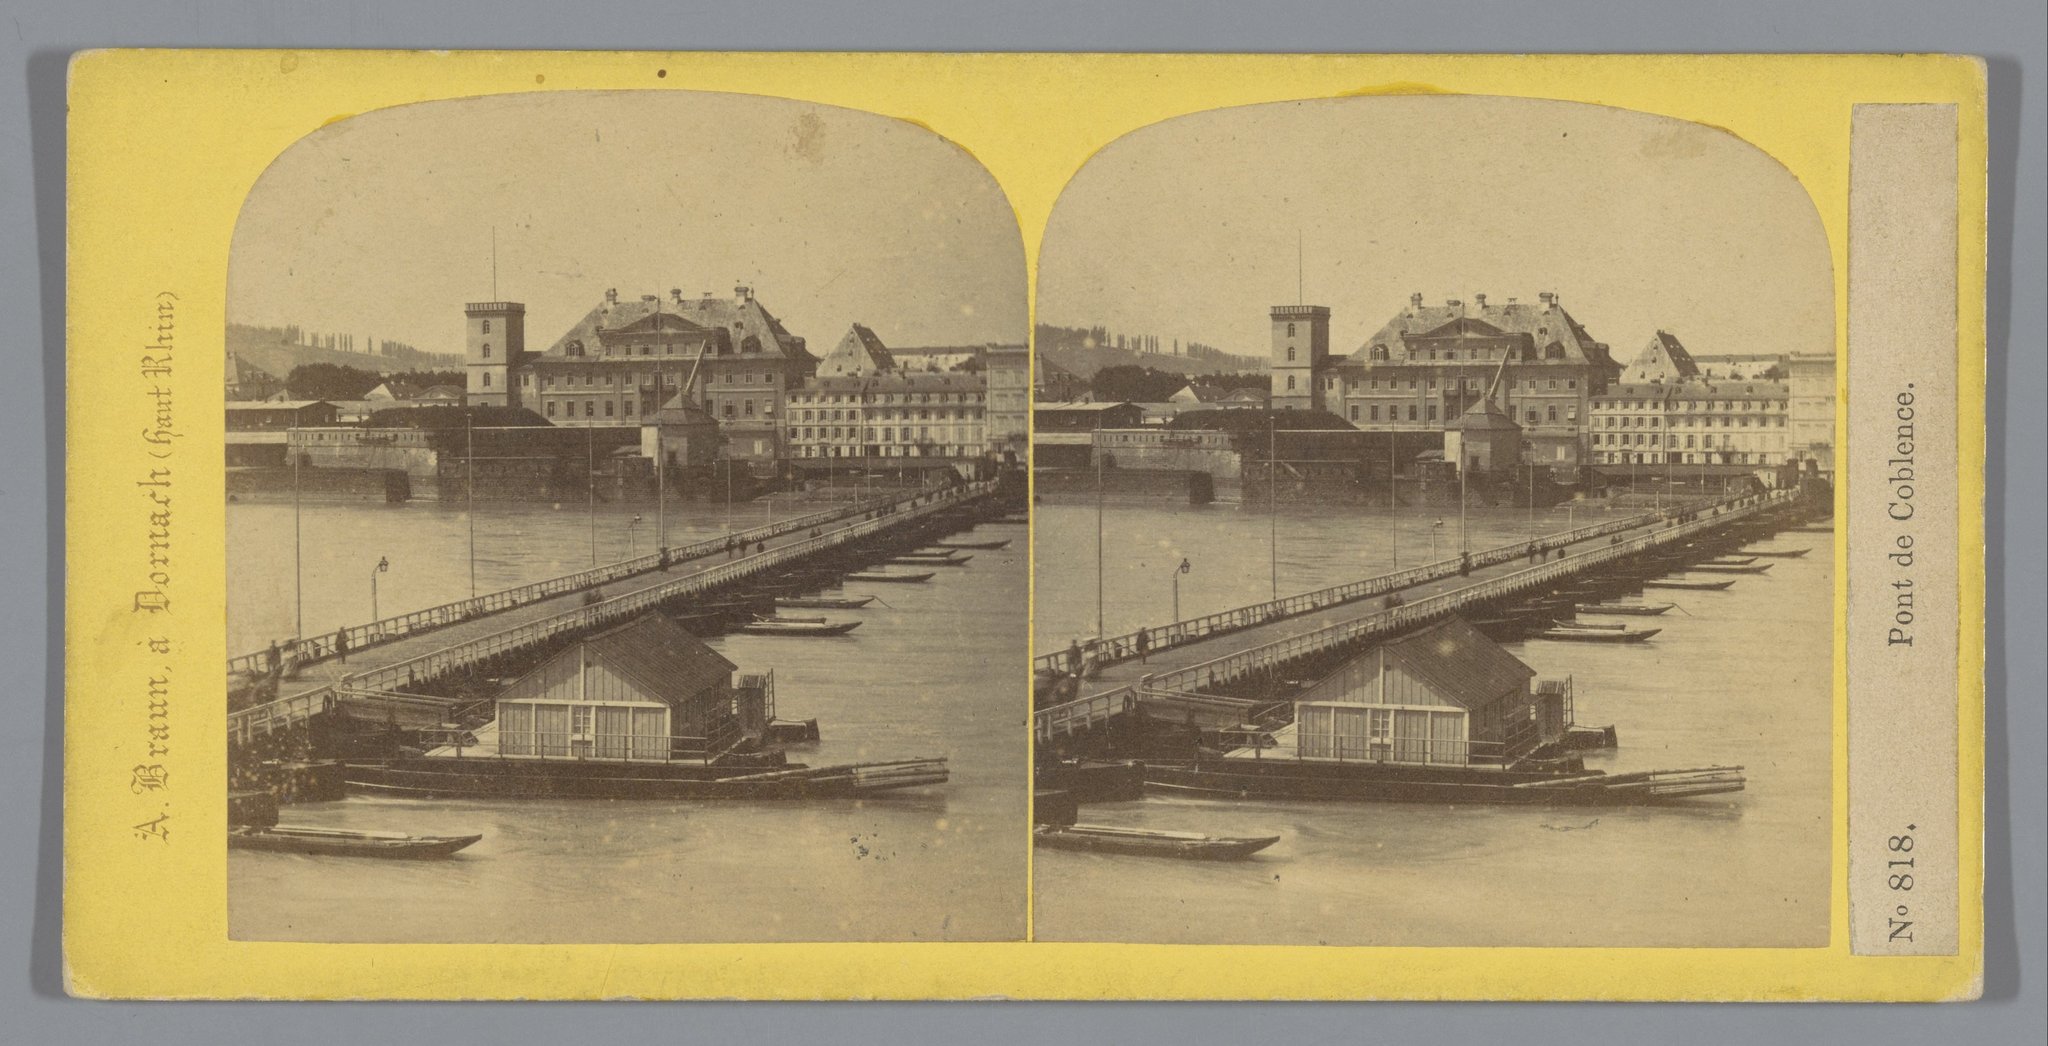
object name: stereograph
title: Pont de Coblence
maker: Anonymous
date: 1860-1866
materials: cardboard, paper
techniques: albumen print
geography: dornach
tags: bridge in city across river, canal, etc.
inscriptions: number: ‘No 818.’